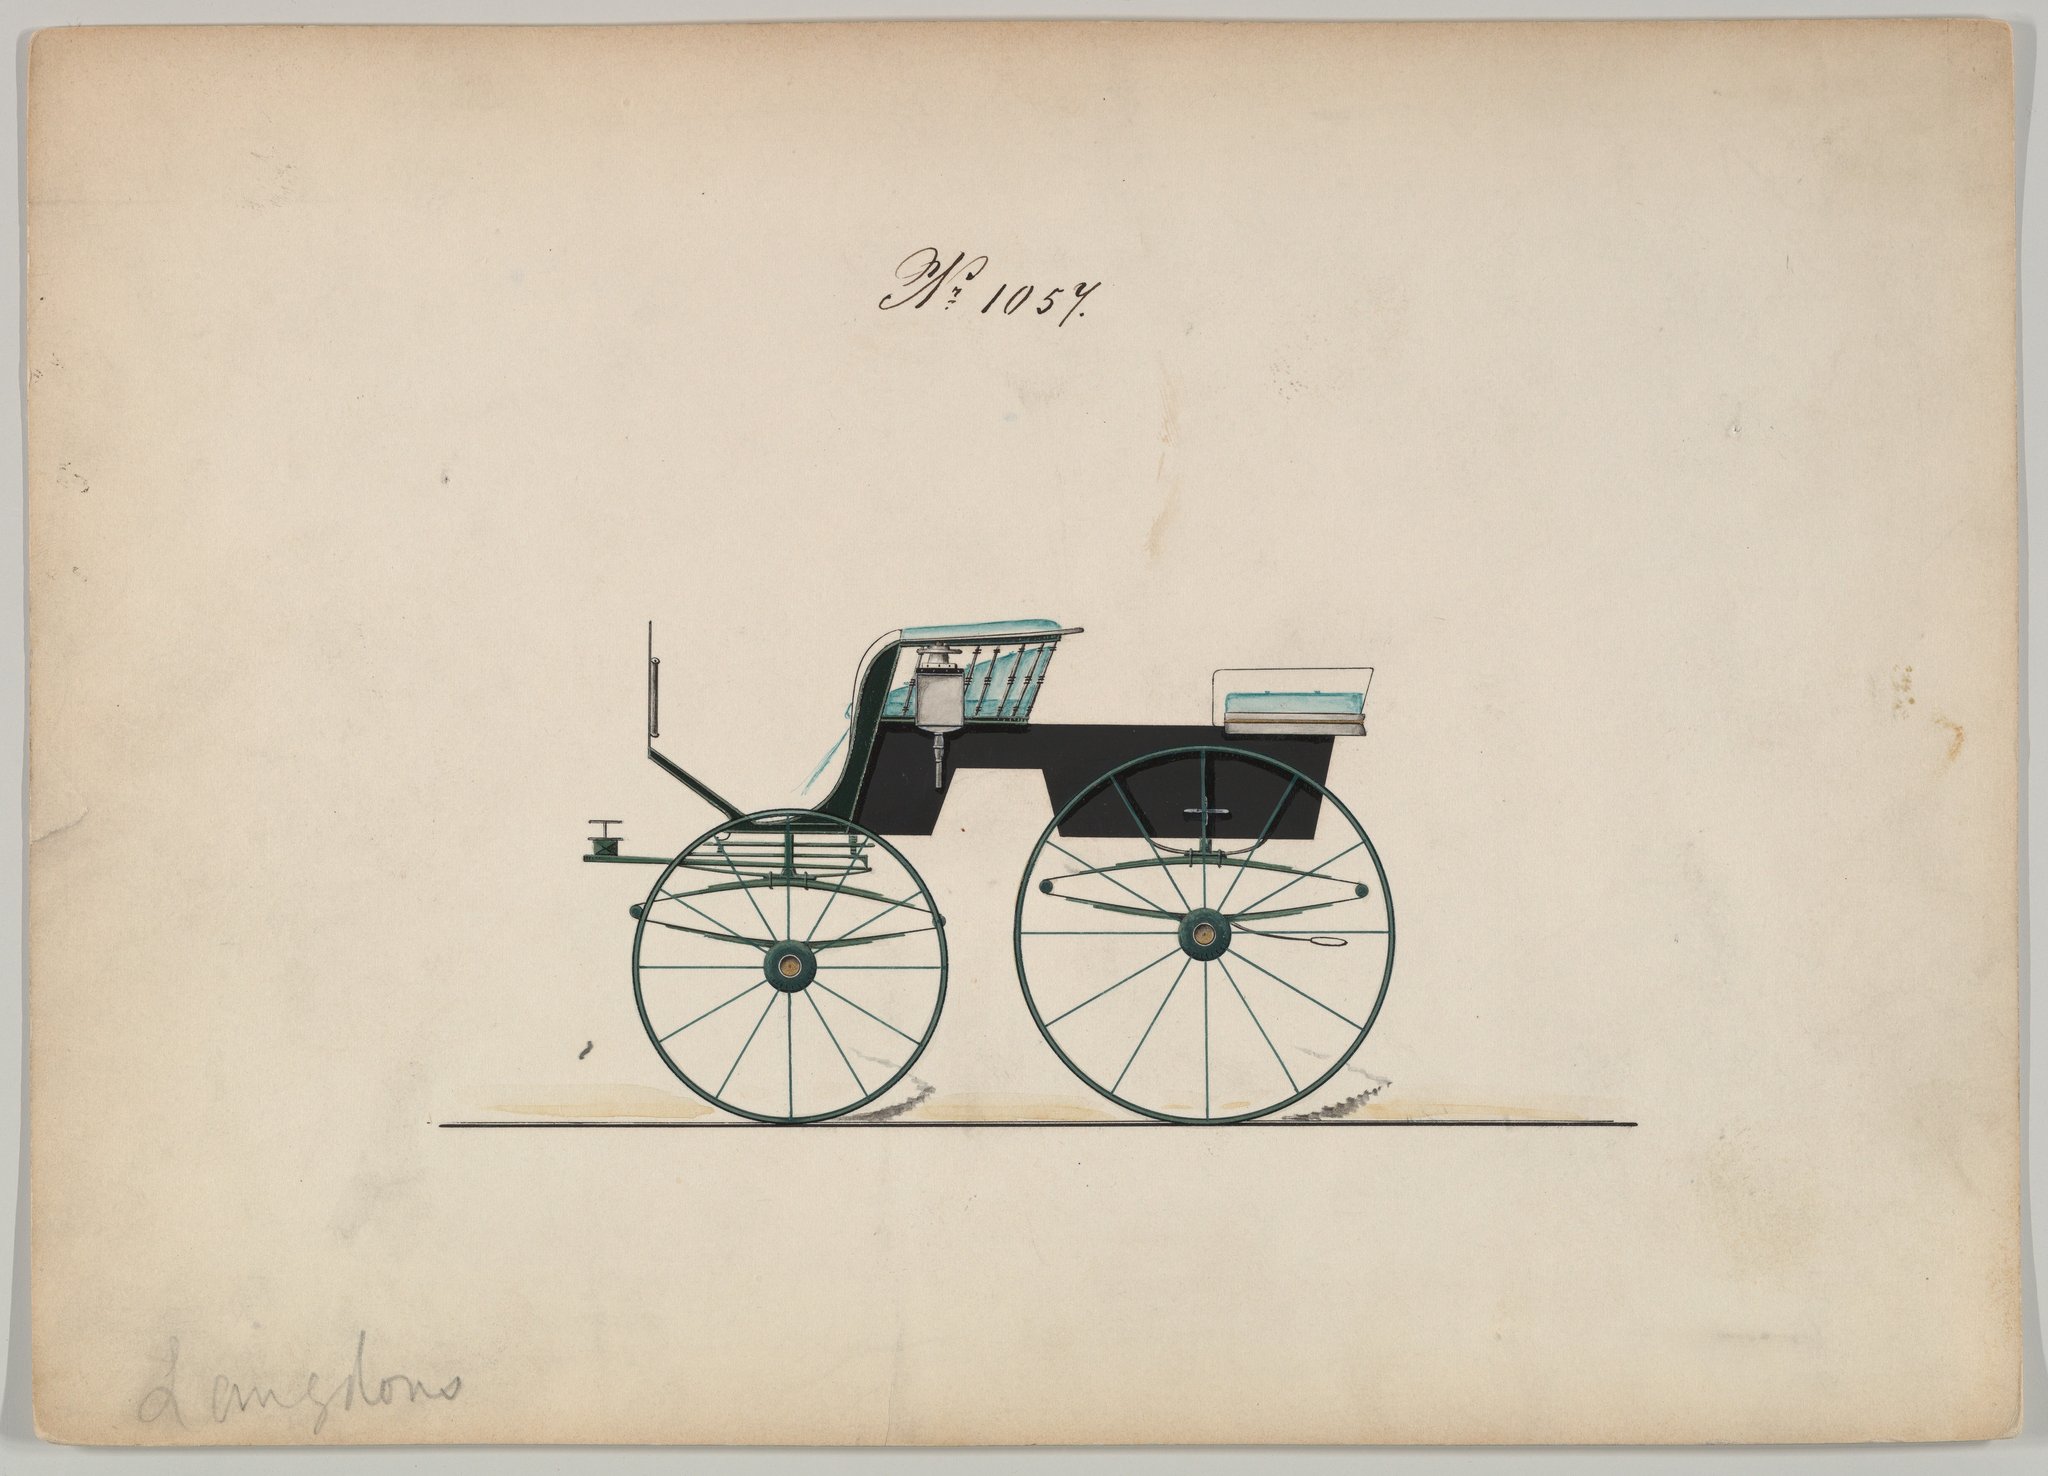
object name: drawing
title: T-Cart Phaeton #1057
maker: brewster & co.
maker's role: manufacturer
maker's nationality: american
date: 1850-1870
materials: ink, watercolor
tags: carriages